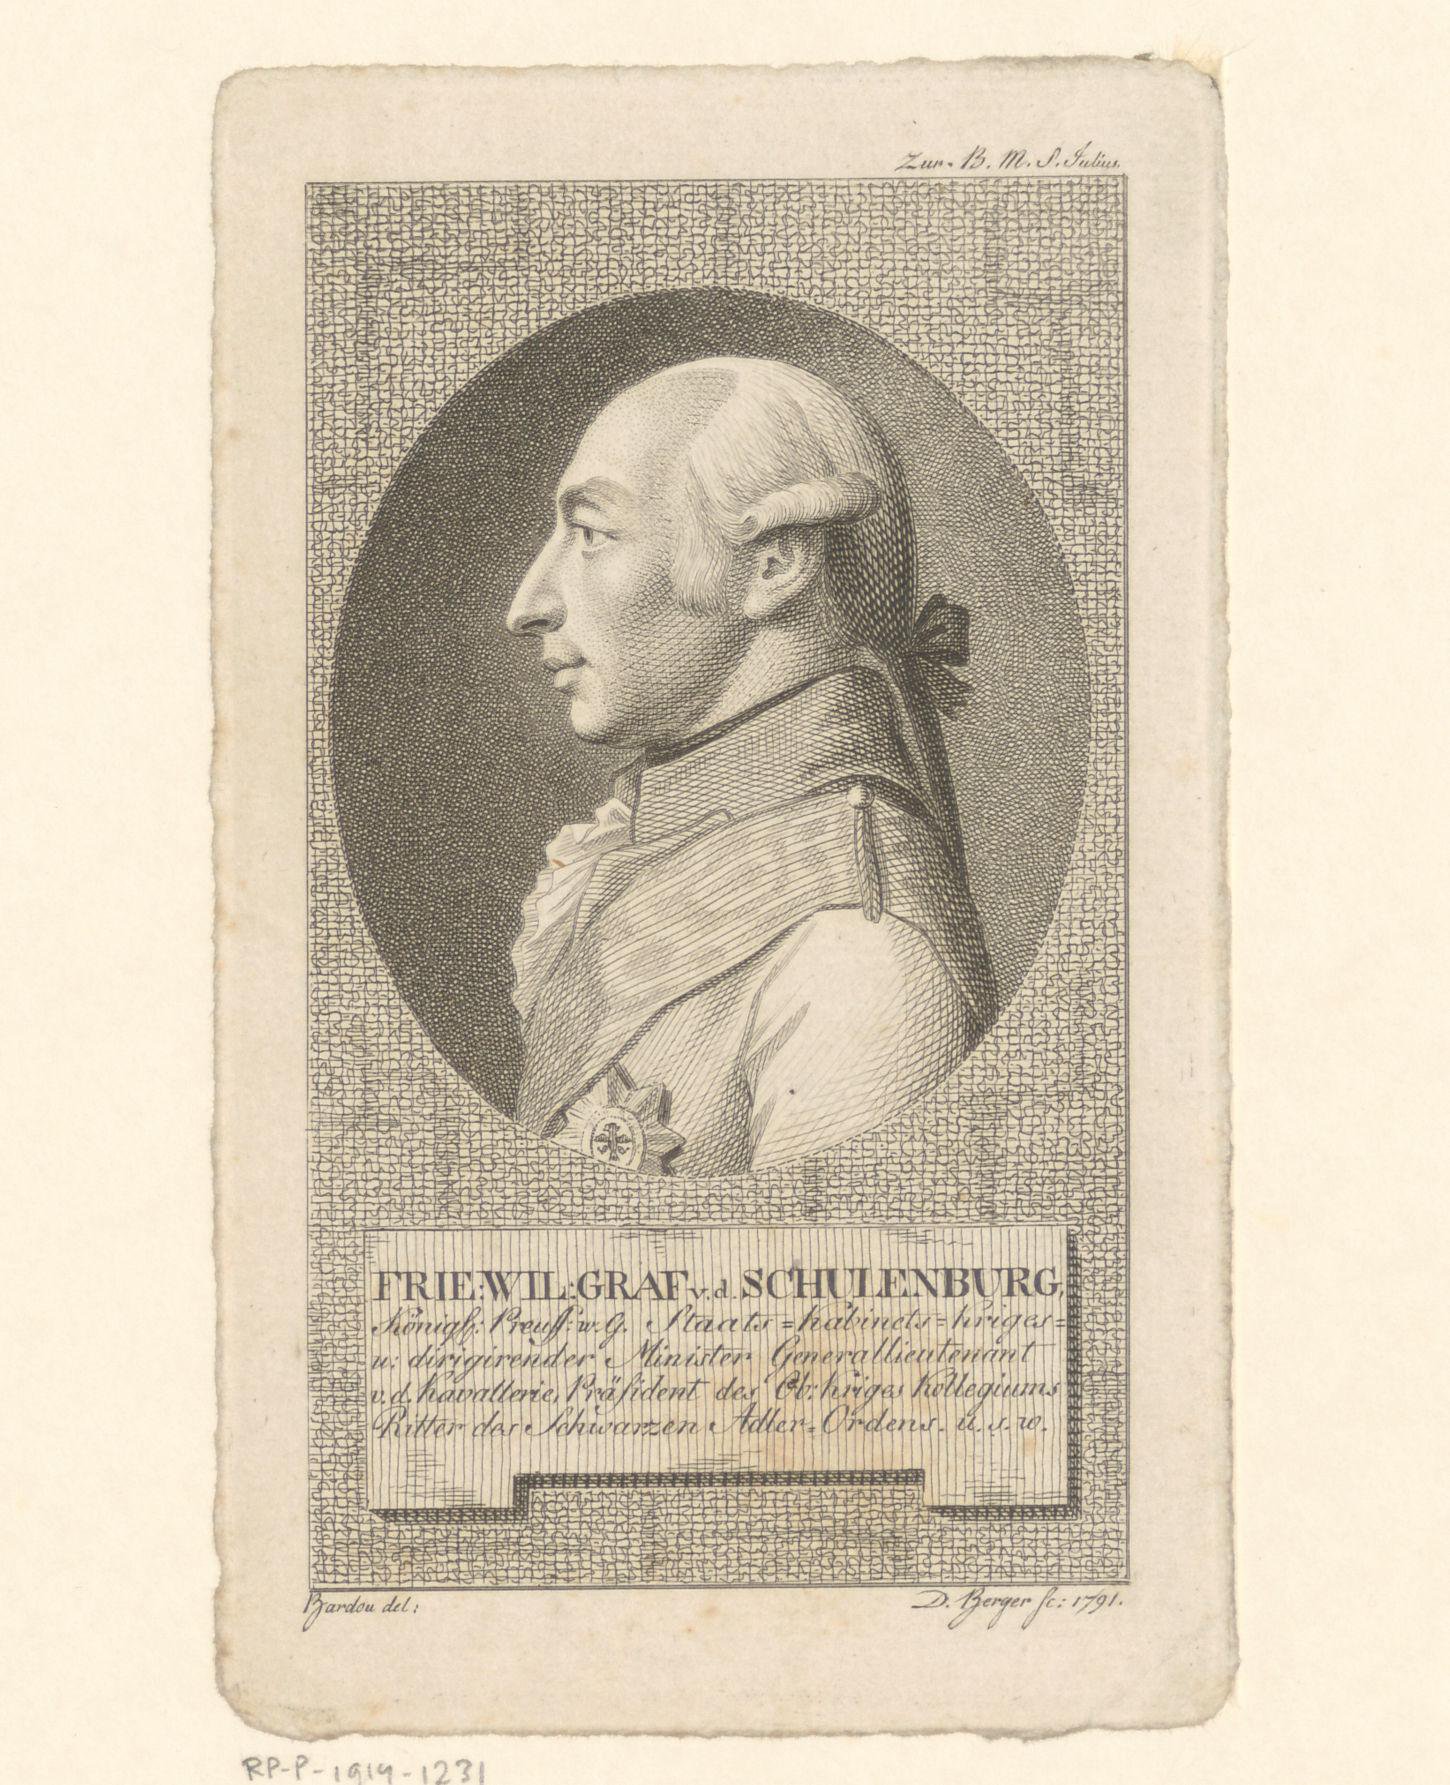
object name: print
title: Portret van Friedrich Wilhelm von der Schulenburg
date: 1791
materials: paper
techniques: engraving, etching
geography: berlin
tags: historical persons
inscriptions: collector's mark: Lugt 2228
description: Prent afkomstig uit: Berlinischen Monatschrift. dl. 18. Berlijn: Haude & Spener, 1791.